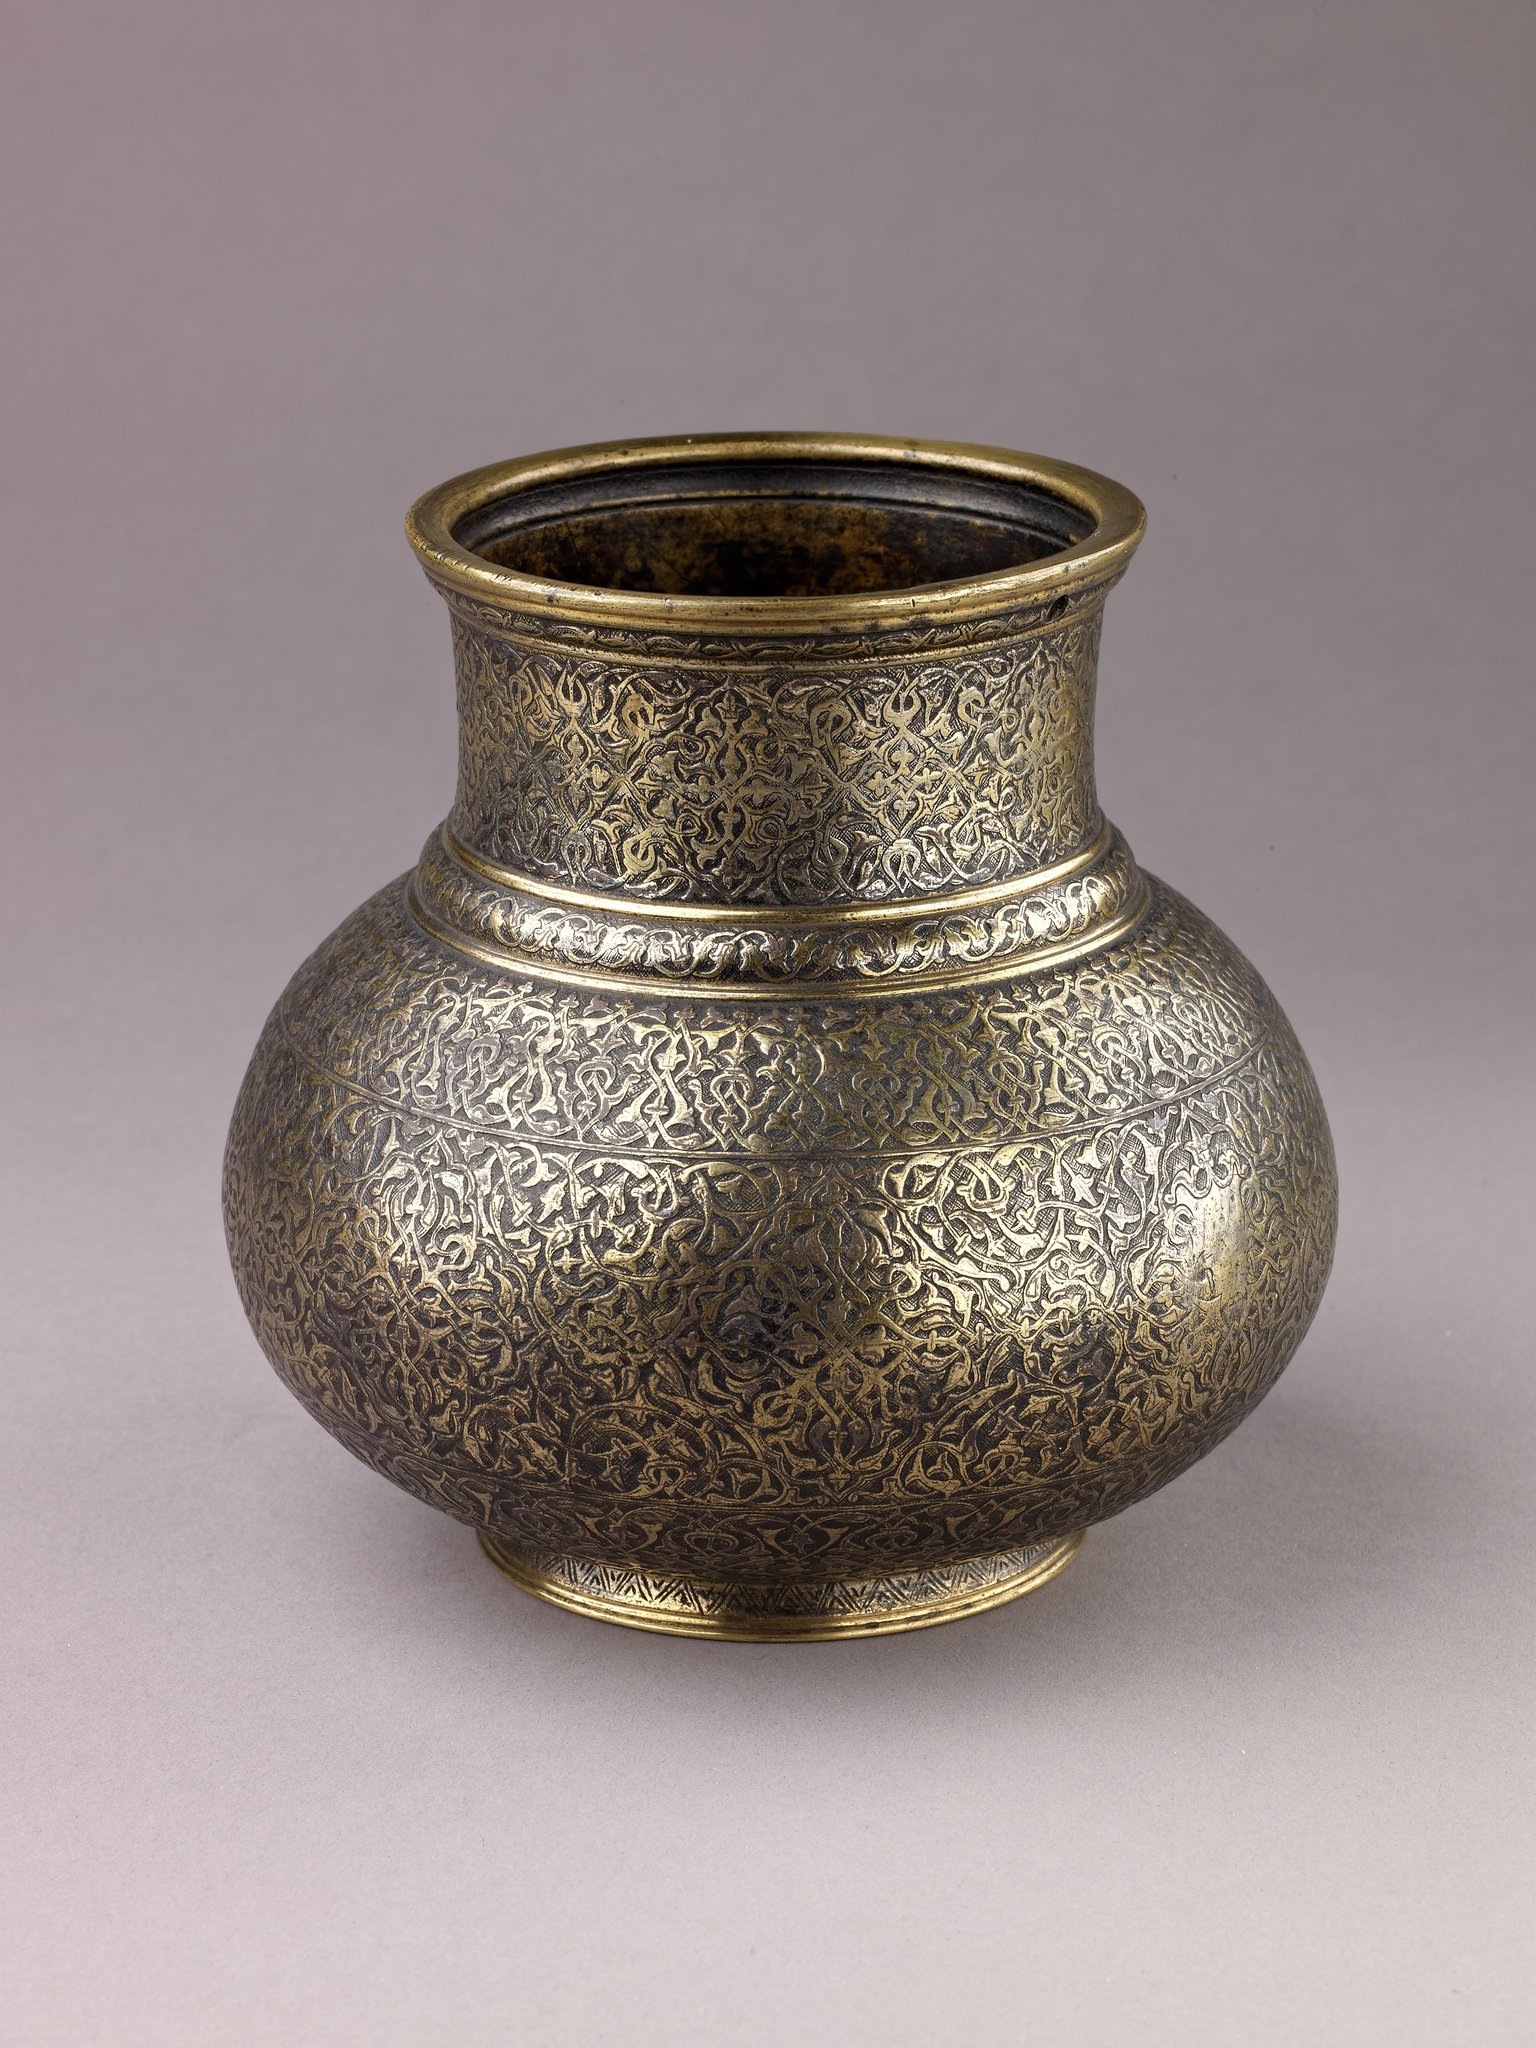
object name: vase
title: Vase with Arabesque Design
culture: syrian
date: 1501-1533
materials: brass, silver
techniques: inlay